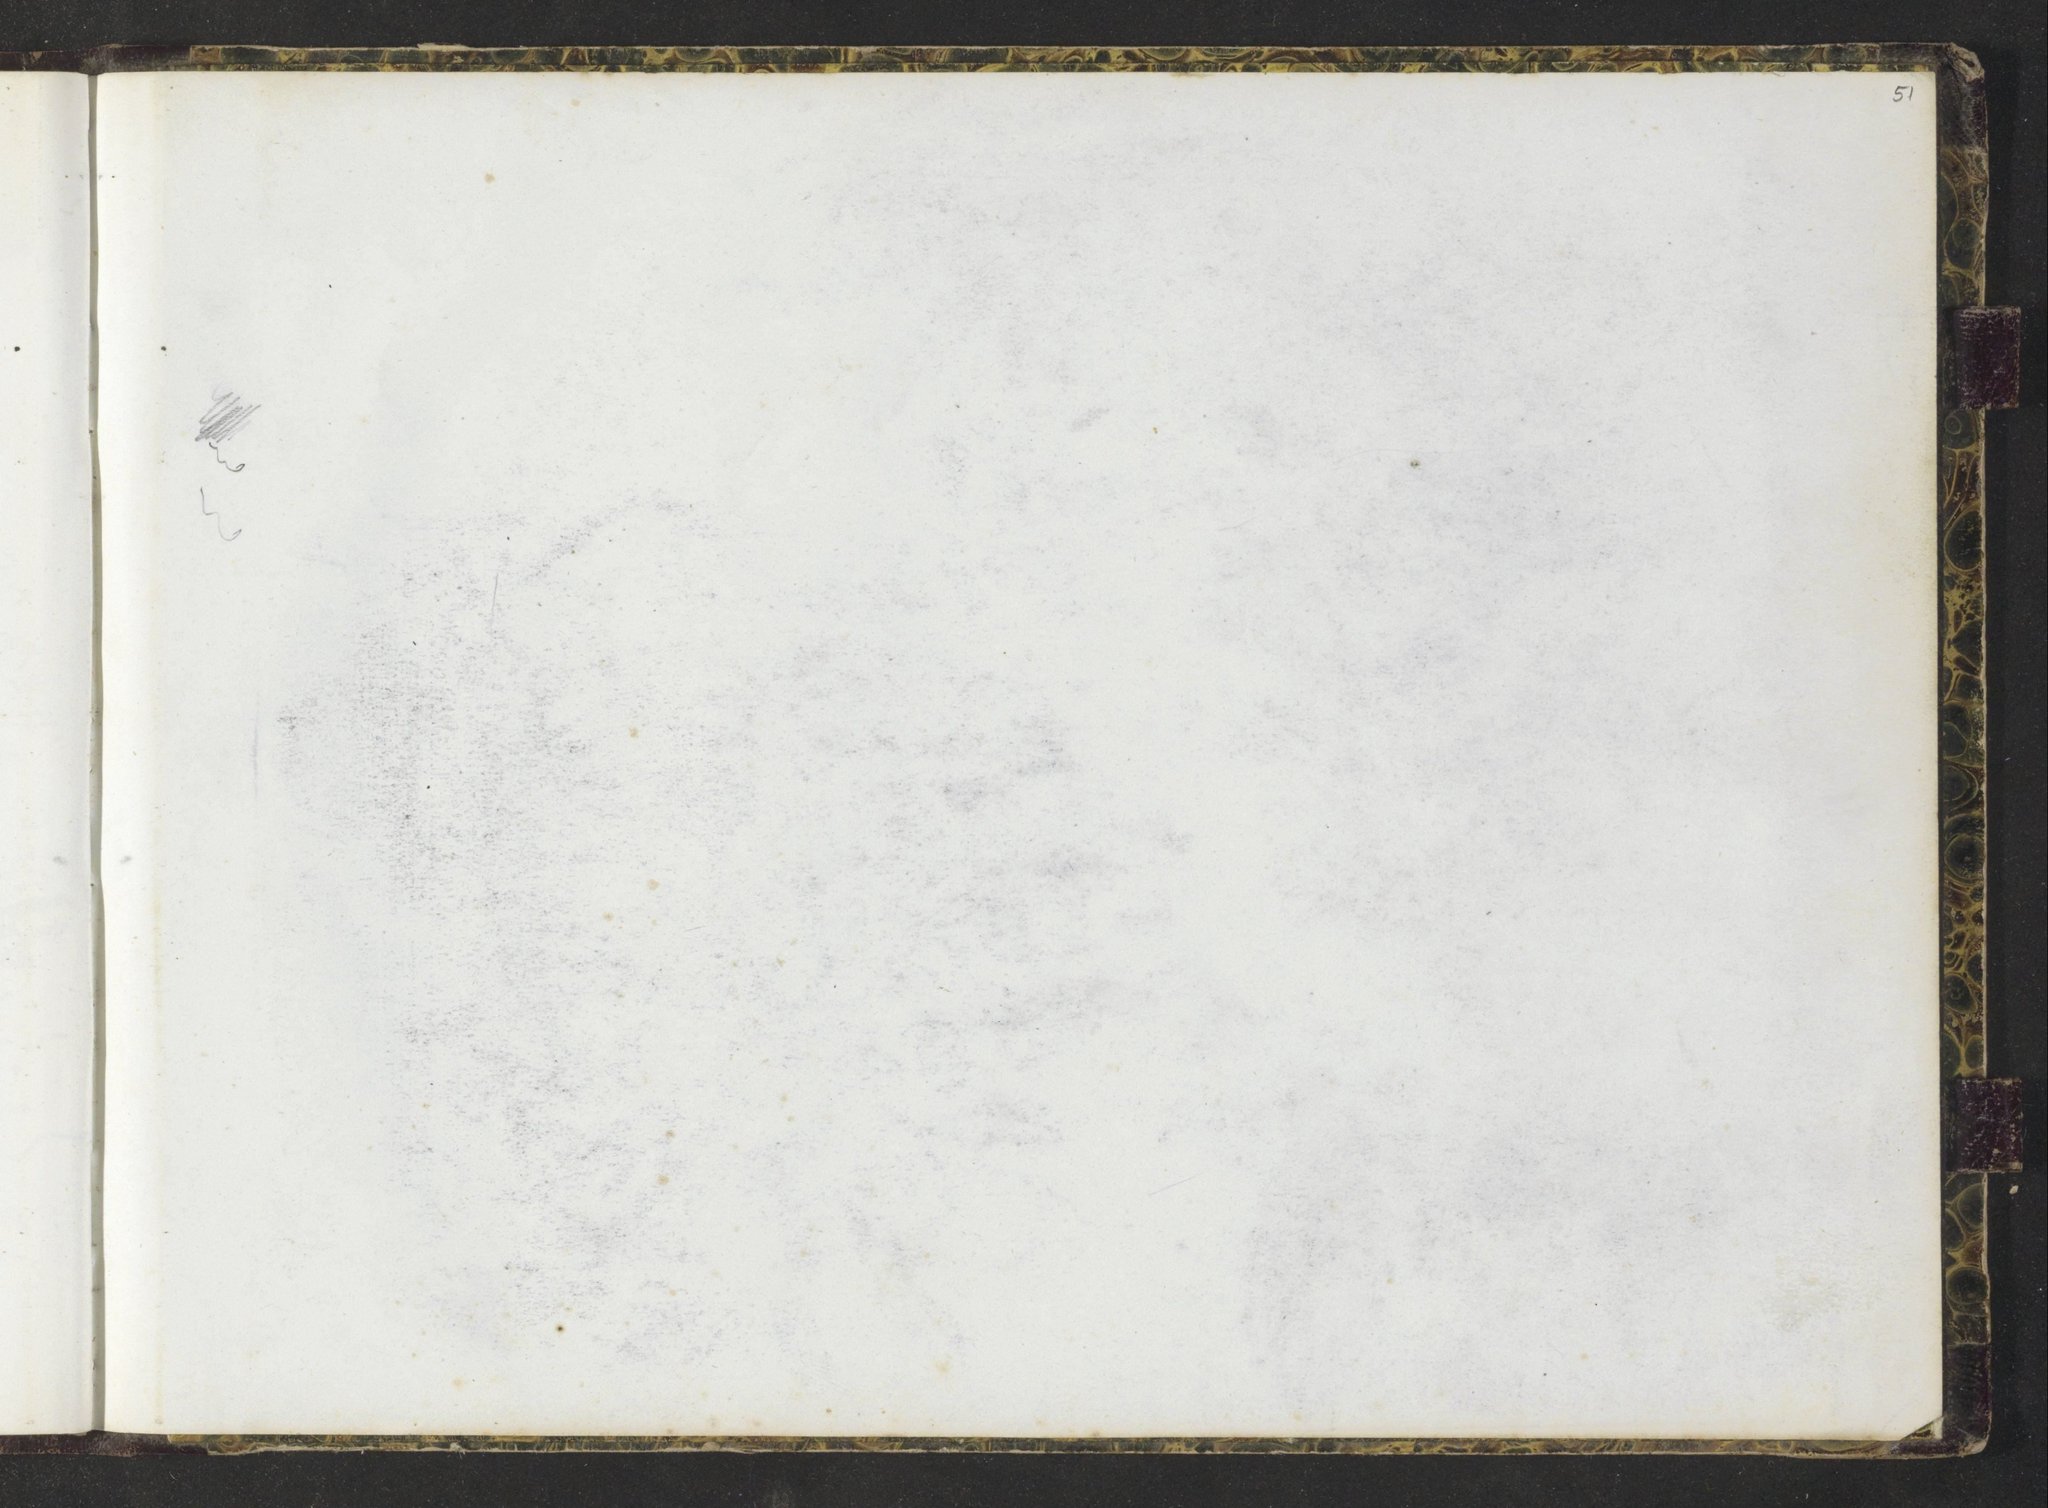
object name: sketchbook leaf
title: Studie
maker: lambertus lingeman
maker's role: draughtsman, painter, print maker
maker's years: 1829-1894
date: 1839-1894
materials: paper, pencil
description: Blad 51 recto uit een schetsboek met 51 bladen.